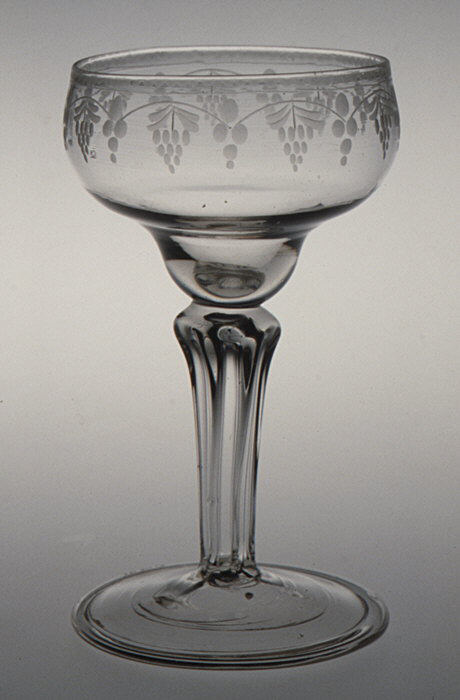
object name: wineglass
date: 1720-1730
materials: glass